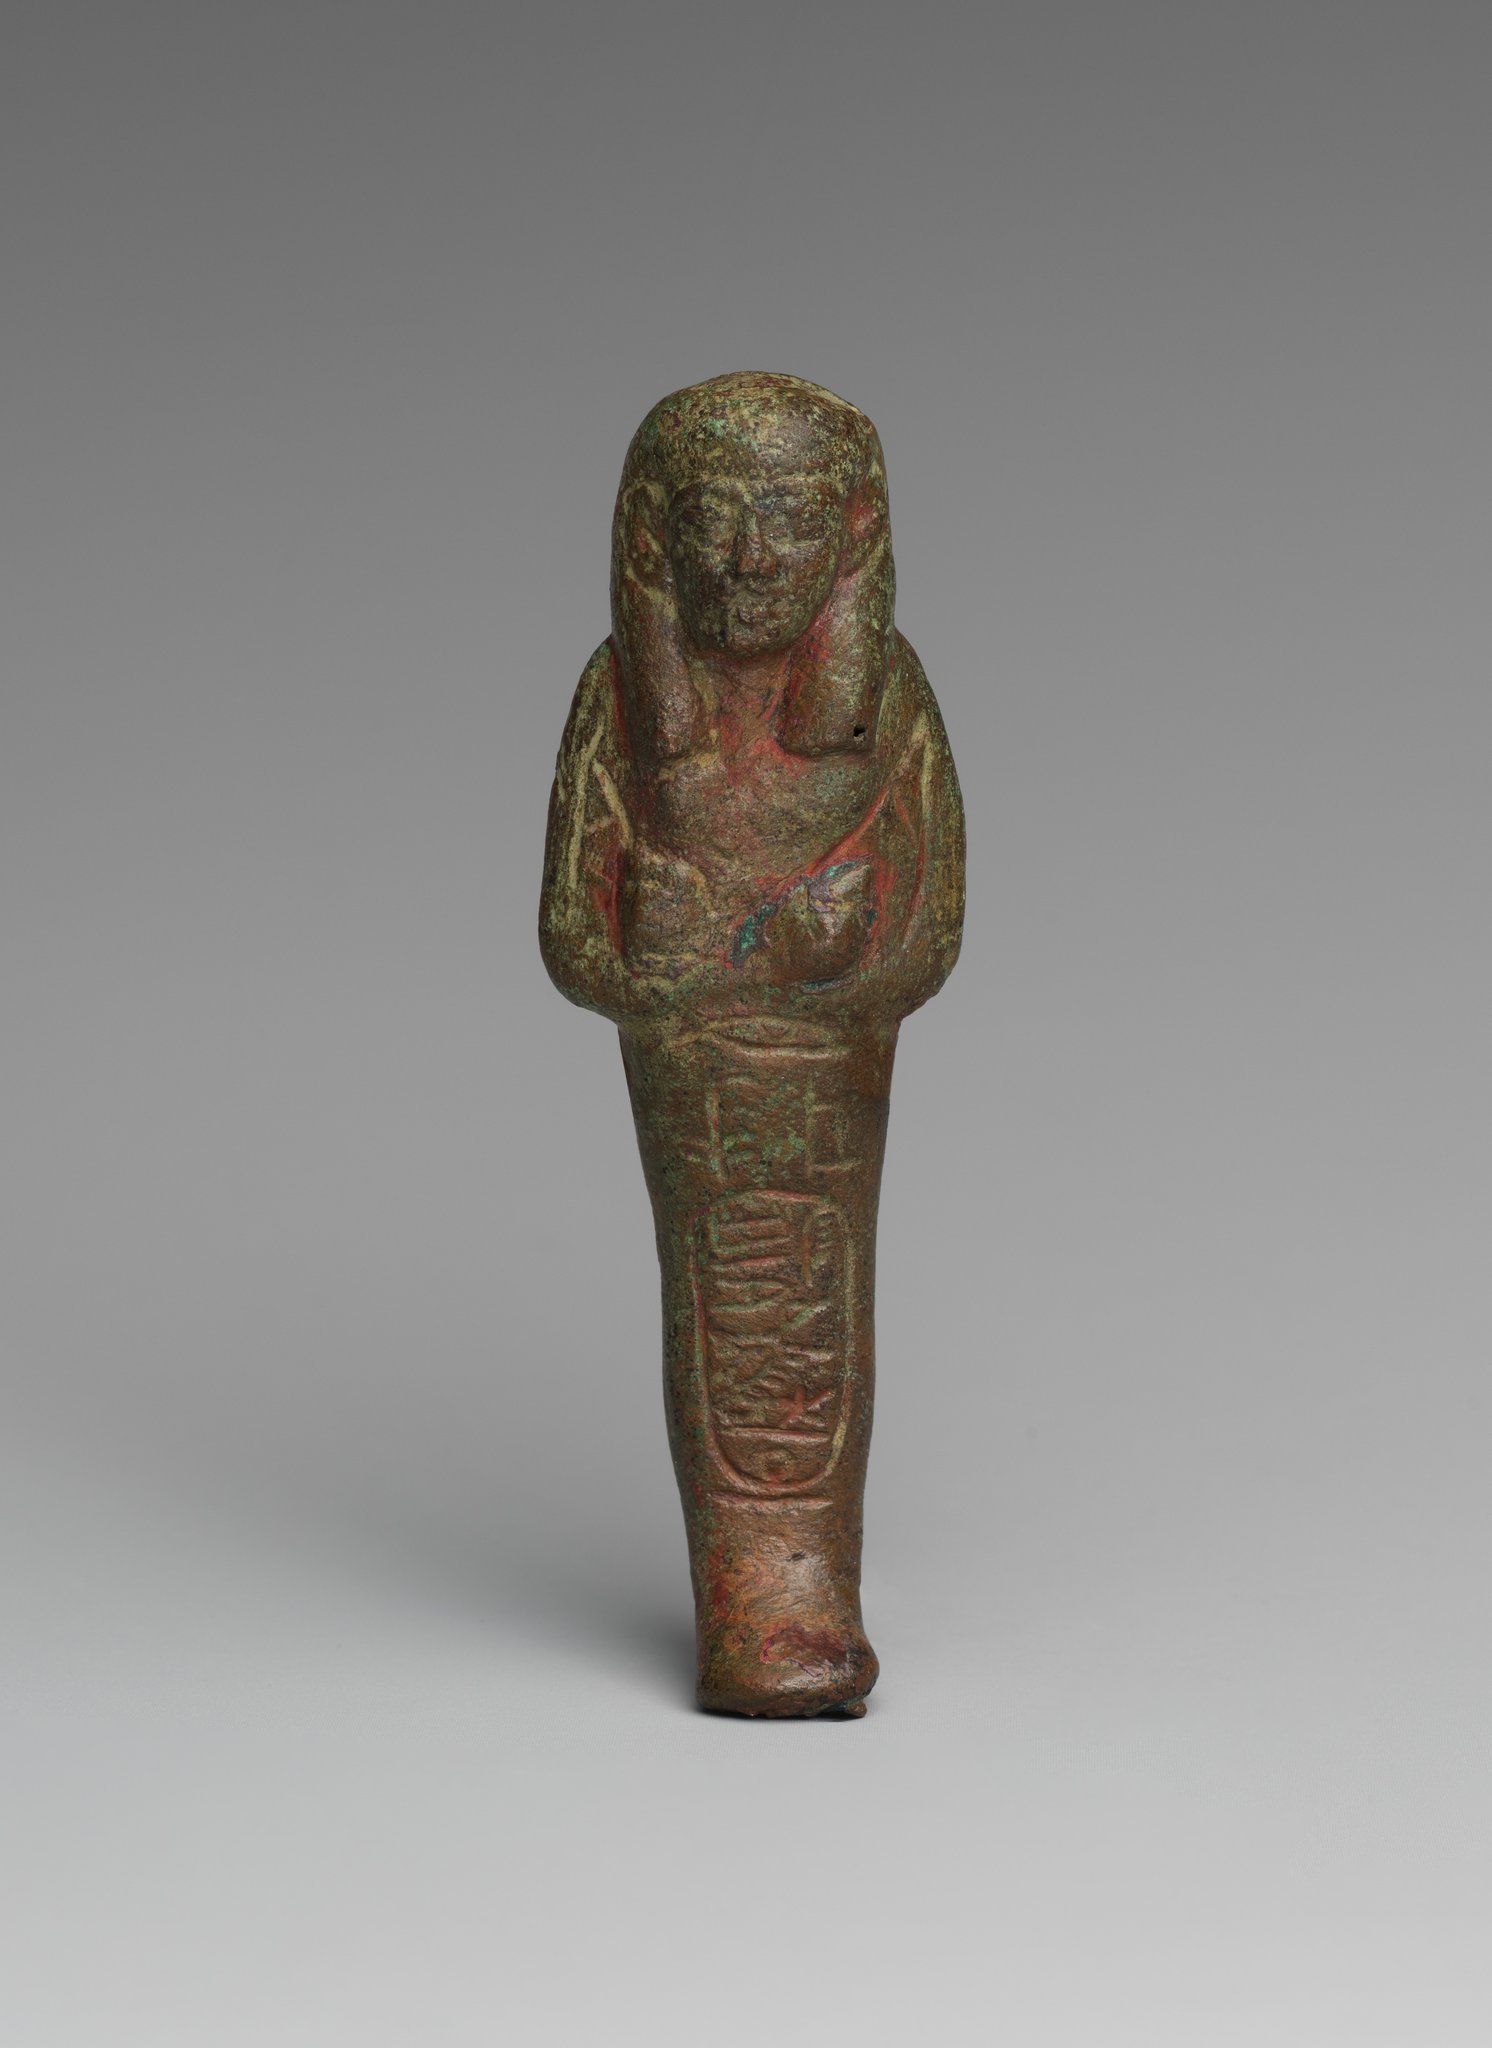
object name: shabti, psusennes i, worker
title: Shabti of Psusennes I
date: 1040-992 BCE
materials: bronze, copper alloy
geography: egypt